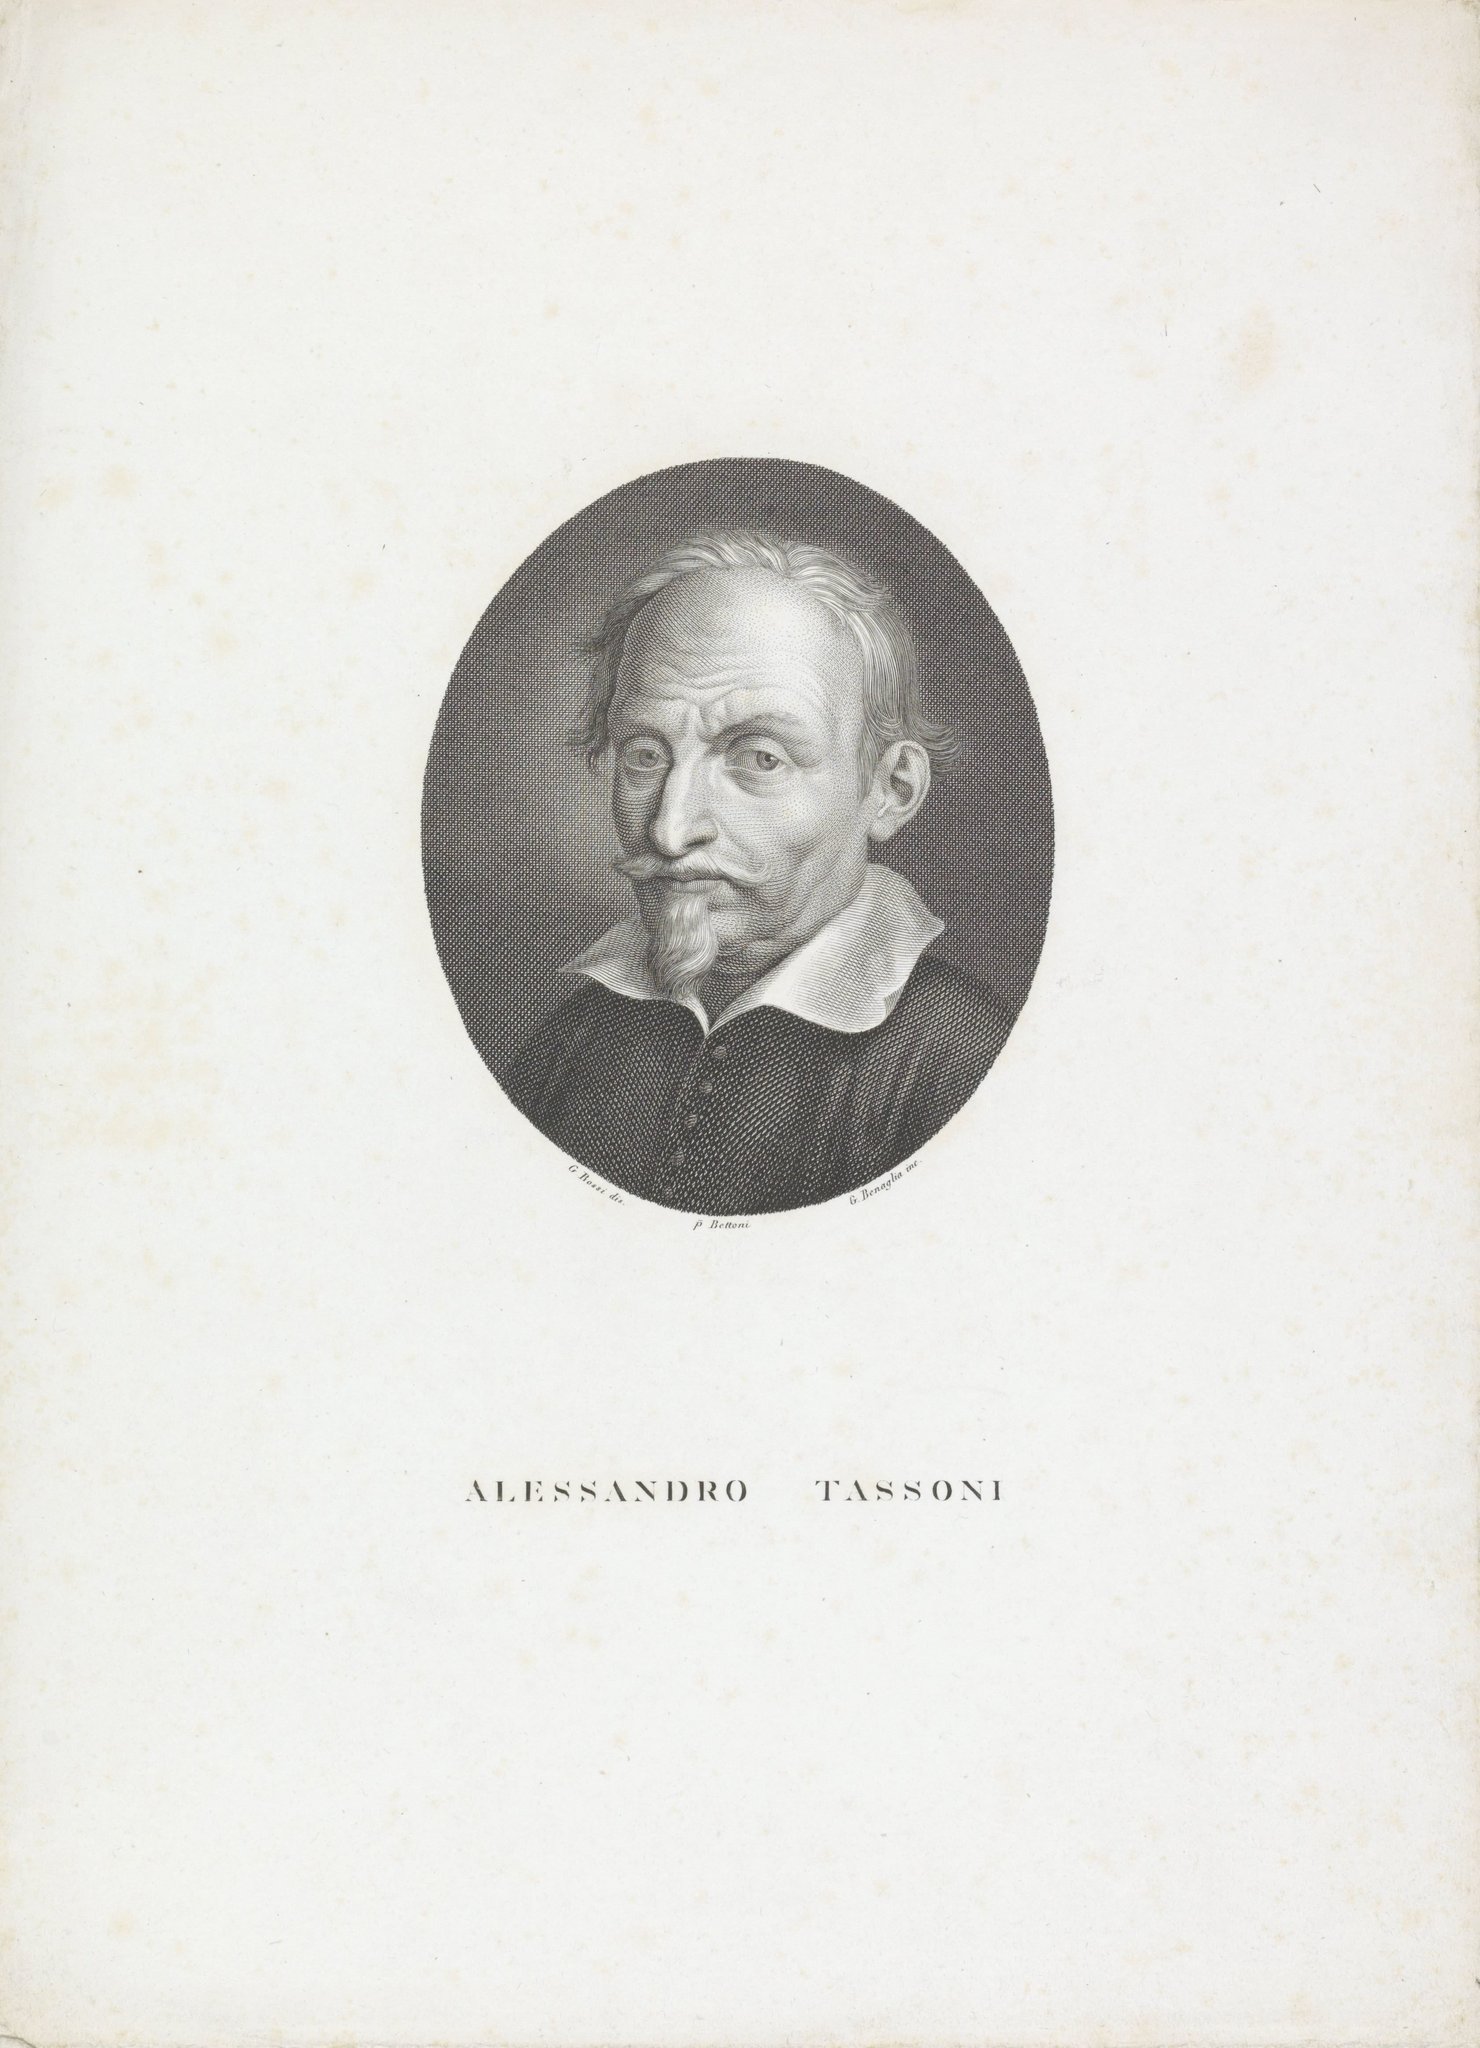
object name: print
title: Portretten van beroemde Italianen in ovalen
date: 1806-1830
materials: paper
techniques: engraving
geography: italy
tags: historical persons, portrait of a writer, writer, poet, author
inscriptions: collector's mark: Lugt 4187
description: Deze prent maakt deel uit van een reeks portretprenten van onbekende omvang. De reeks is in meerdere staten uitgegeven. De eerste staat met enkel het portret in ovaal. Een tweede staat met naam van de geportretteerde in holle letters onder de voorstelling. Een derde staat met de naam van de geportretteerde in gevulde letters onder de voorstelling. En een vierde staat met een rechthoekig kader rondom het ovale portret.